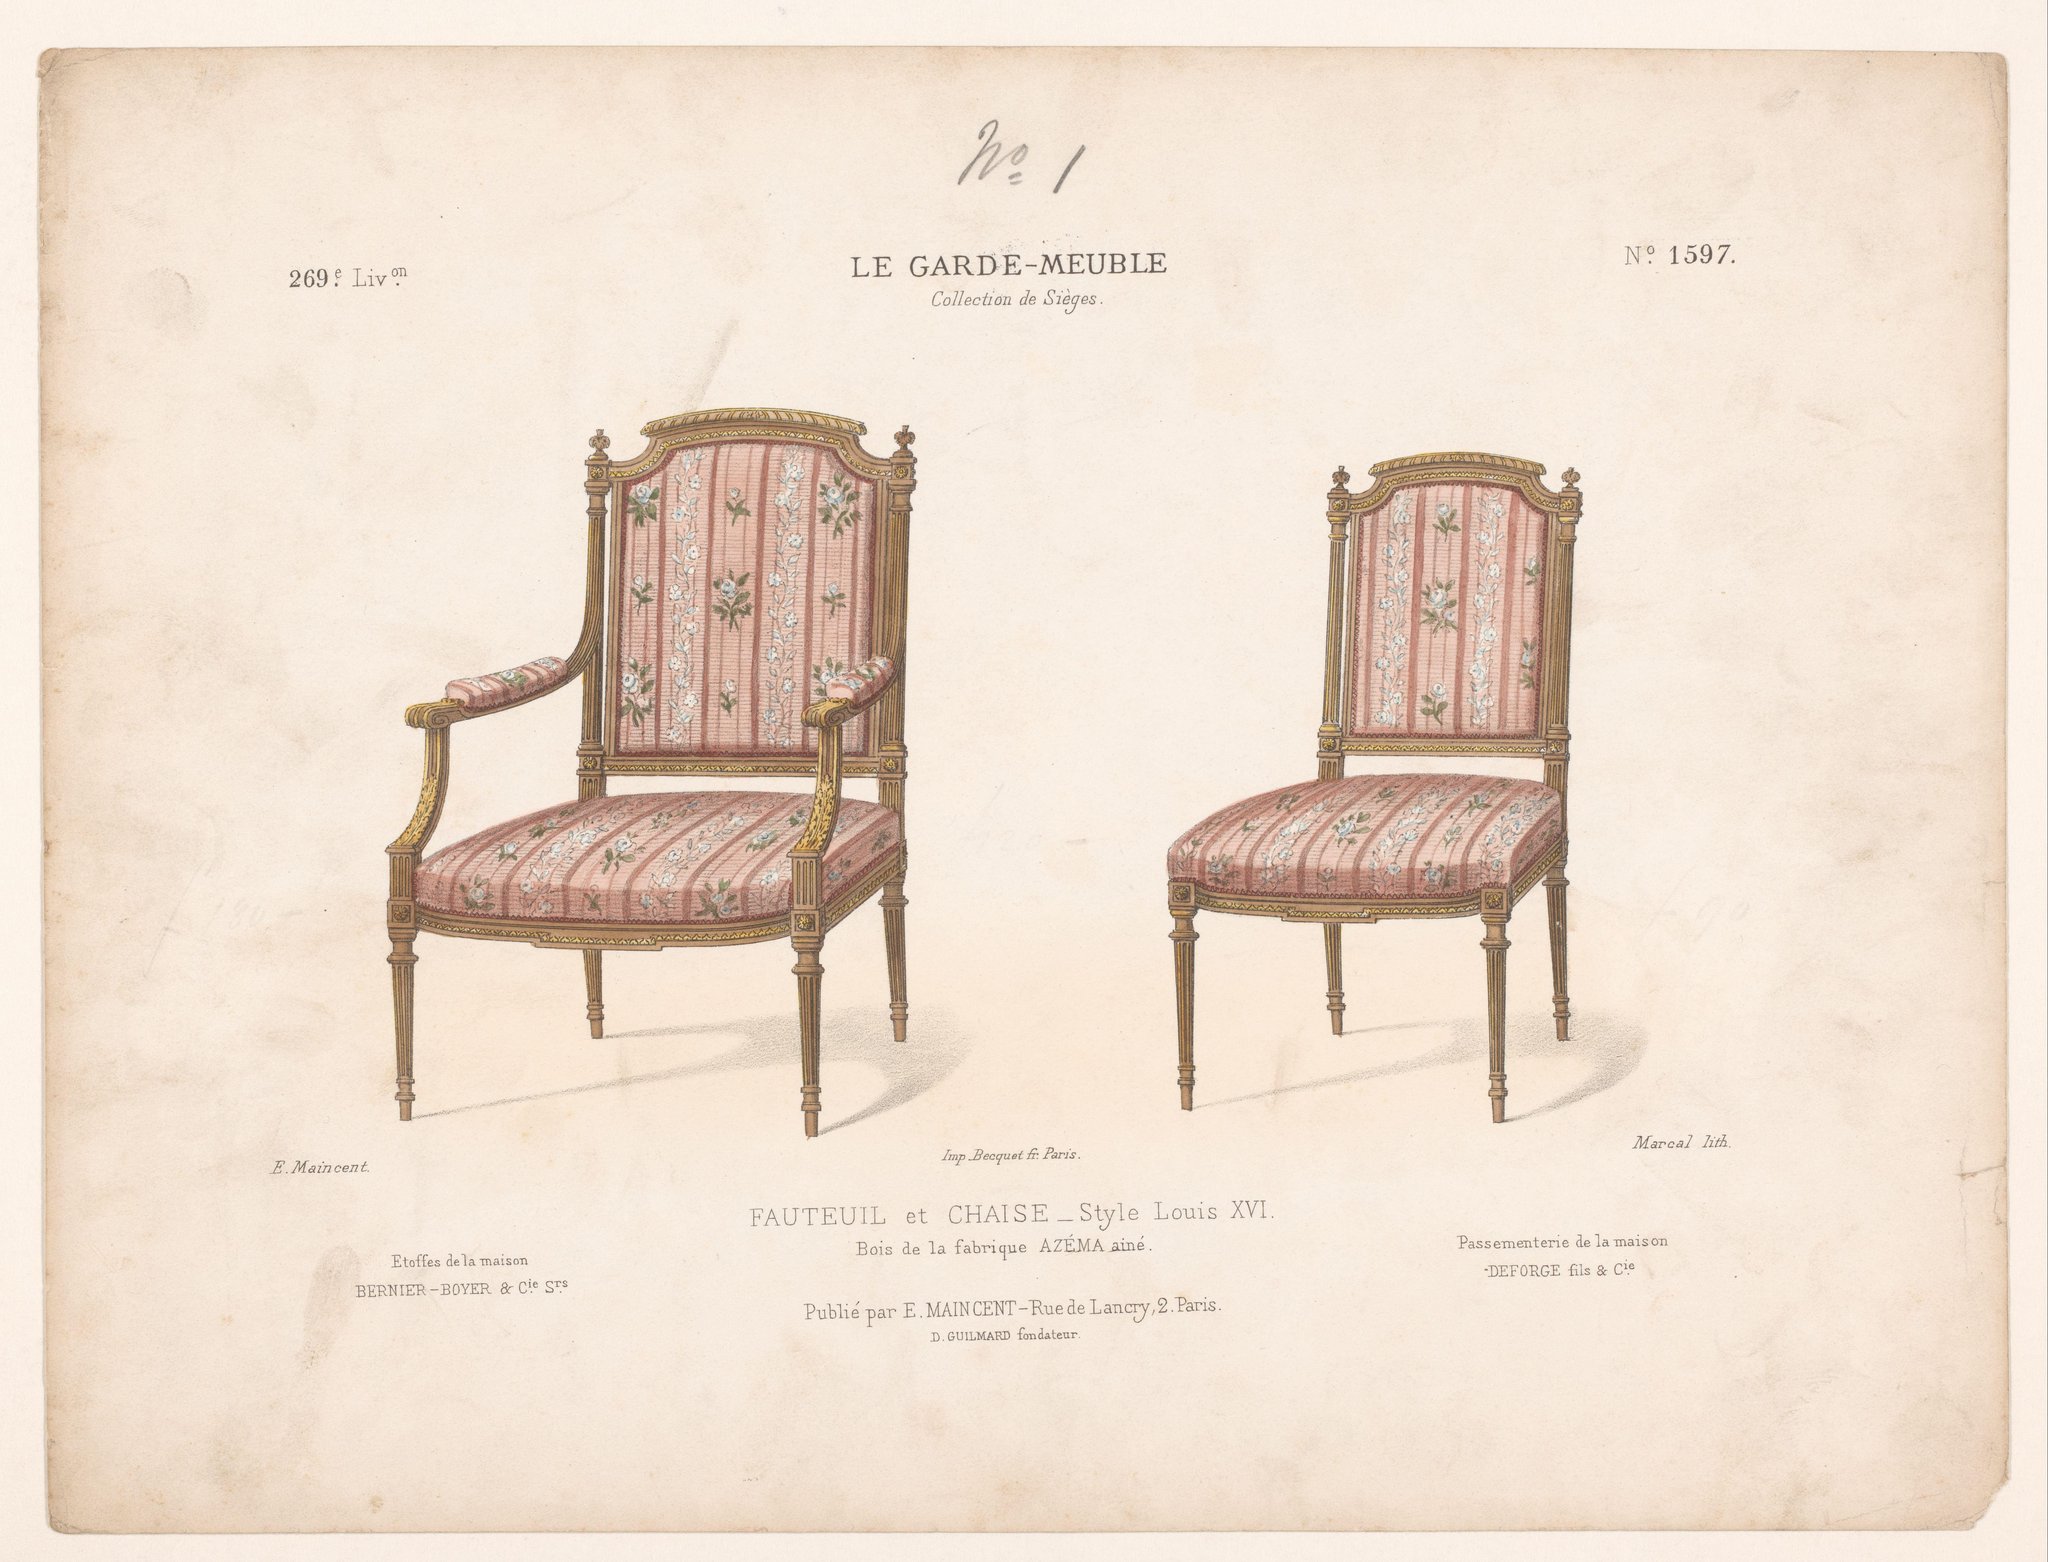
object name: print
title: Fauteuil et chaise Style Louis XVI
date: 1885-1895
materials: paper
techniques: hand coloring, lithograph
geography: paris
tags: seating furniture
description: Ieder Livraison in de serie Le Garde-Meuble bevat negen platen: drie 'sièges' (zitmeubels), drie 'meubles' (diverse meubels zoals tafels en kasten) en drie 'tentures' (gordijnen en draperieën).